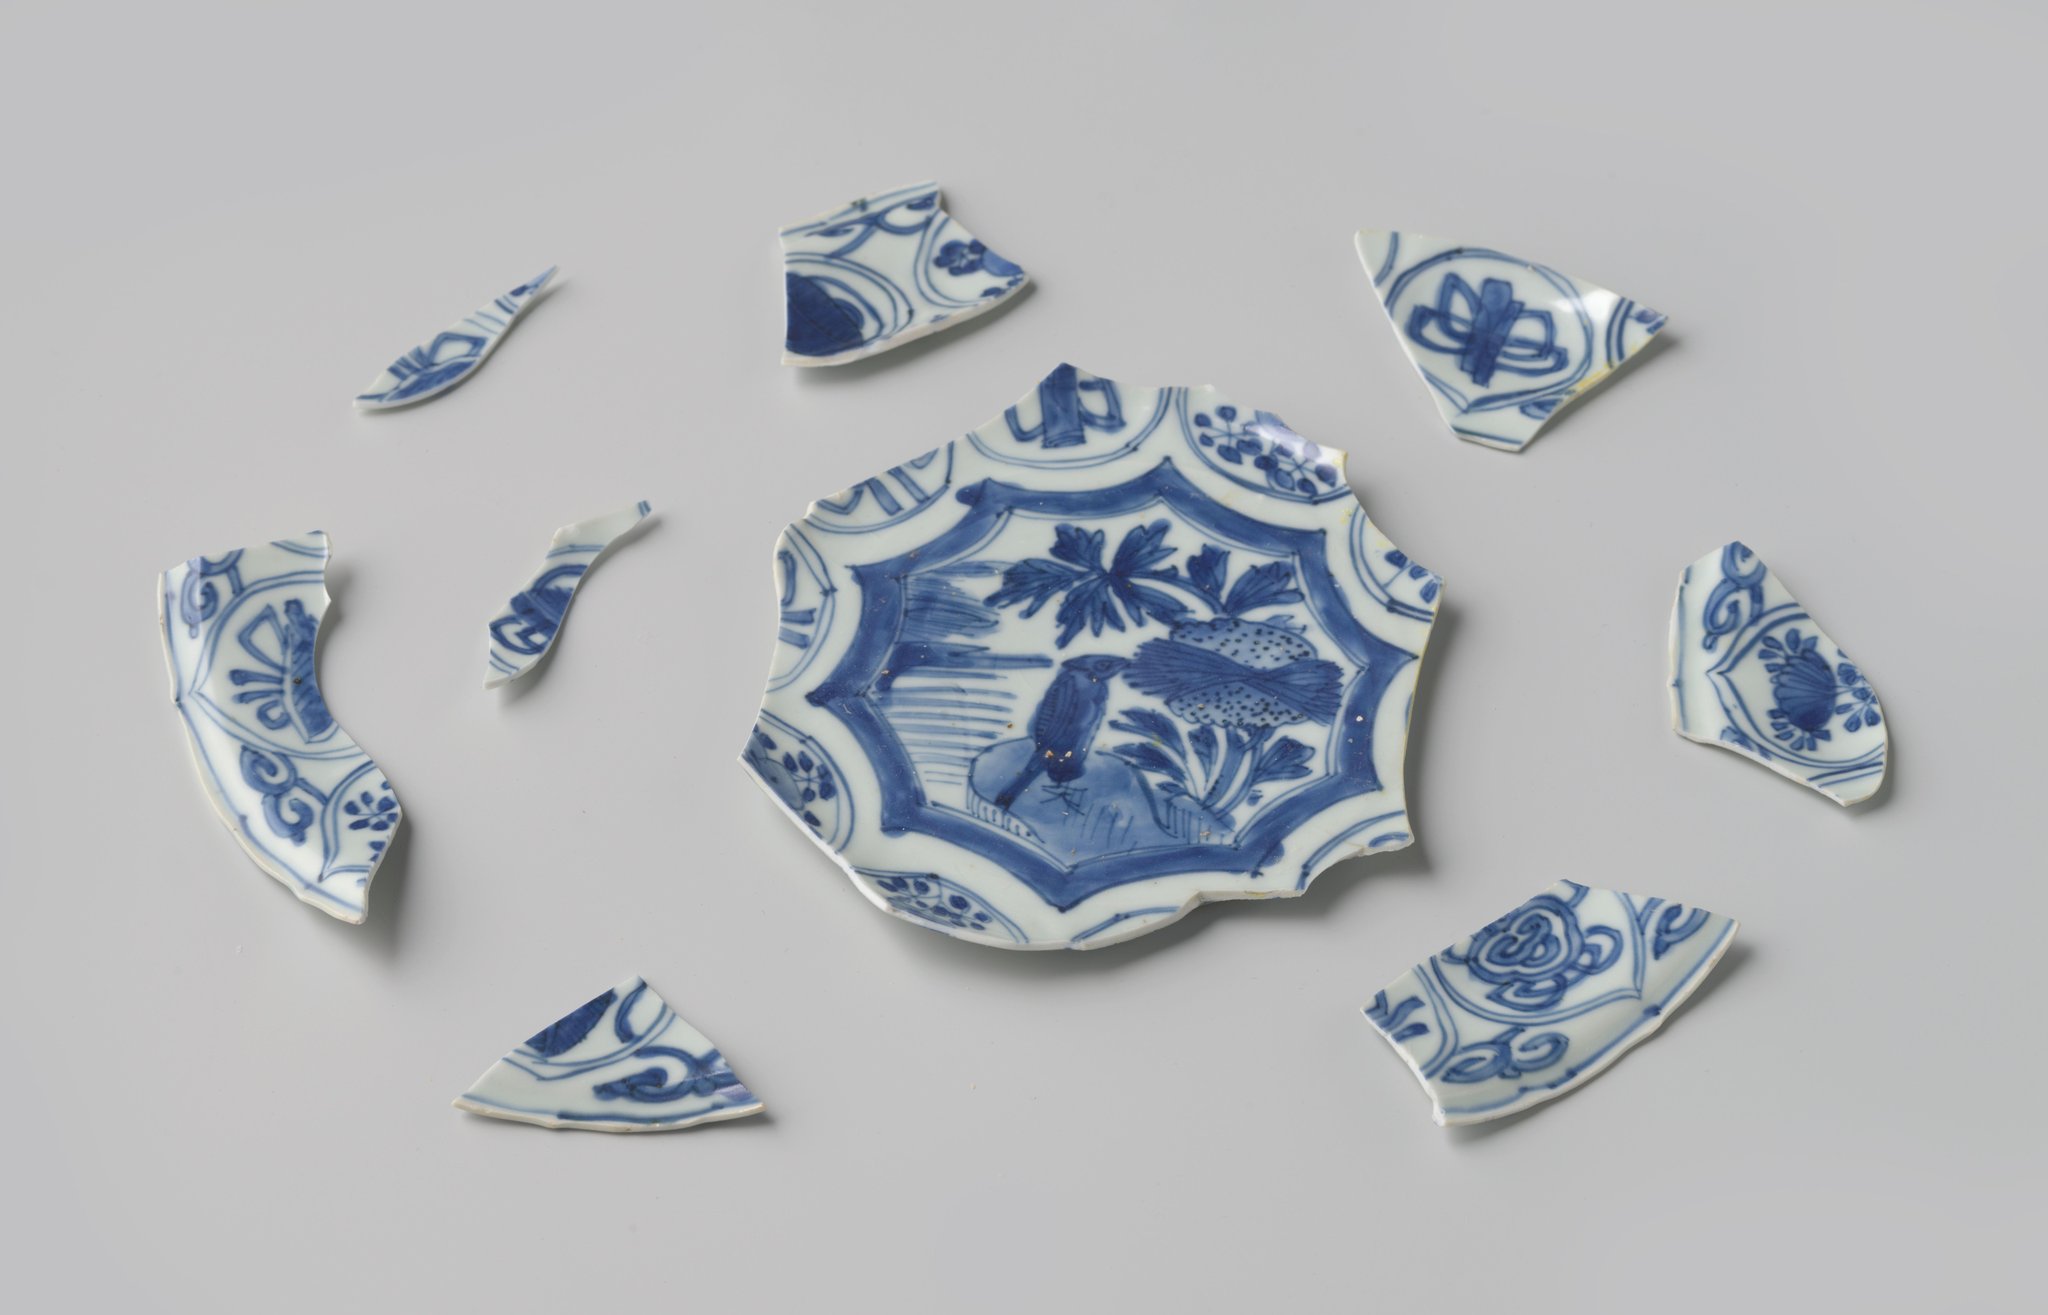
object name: sherd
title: Scherven van een bord uit V.O.C.-schip de 'Witte Leeuw'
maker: Anonymous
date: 1613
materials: bone china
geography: jingdezhen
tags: verenigde oostindische compagnie, sint-helena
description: A dish without a flattened rim. An eight-sided thickly drawn medallion. A central decoration of a bird on a rock and a strange kind of flower or fruit. The medallions decorated alternately with thrice a flower or peach and twice a symbol.